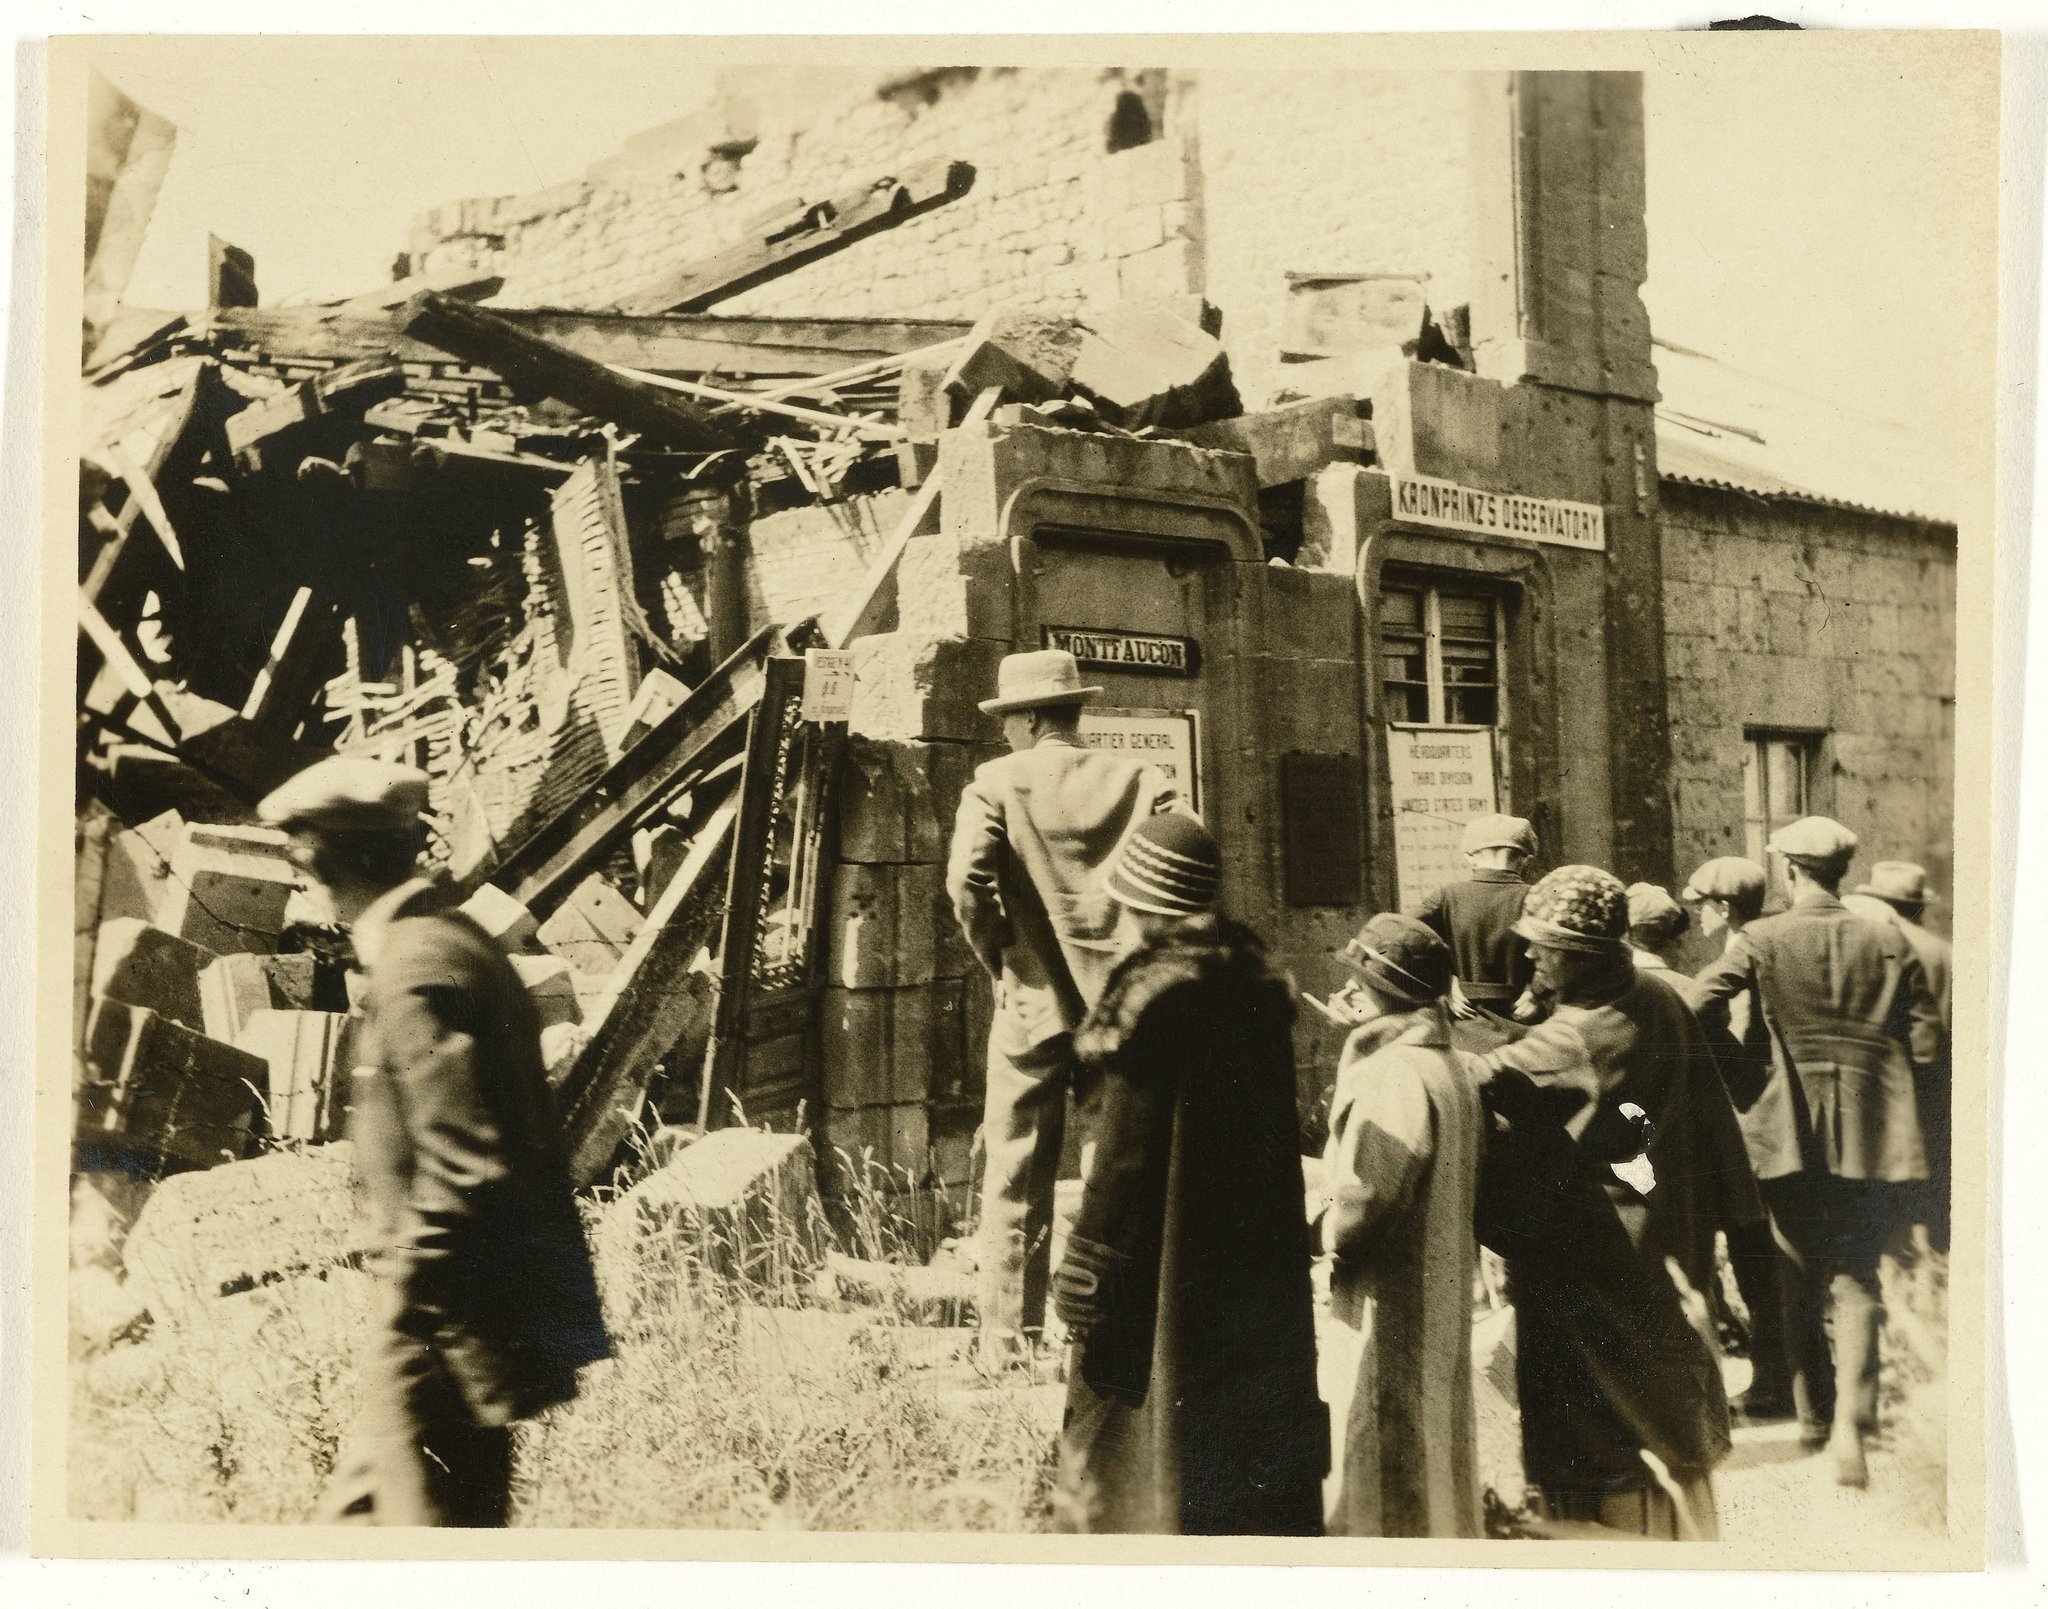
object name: photograph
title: Groep Amerikaanse toeristen bij de ruïnes van de 'Kronprinz Observatory' (Fest Kronprinz of Fort Driant) in of bij Montfaucon, Frankrijk, vernield tijdens de Eerste Wereldoorlog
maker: Anonymous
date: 1921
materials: paper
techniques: gelatin silver print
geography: north and central america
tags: tourism, devastated, ruined place or city (~ warfare), france